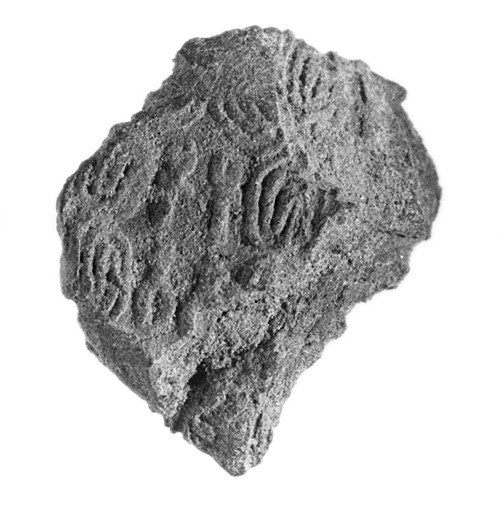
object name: sealing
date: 1981-1640 BCE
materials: mud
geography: egypt